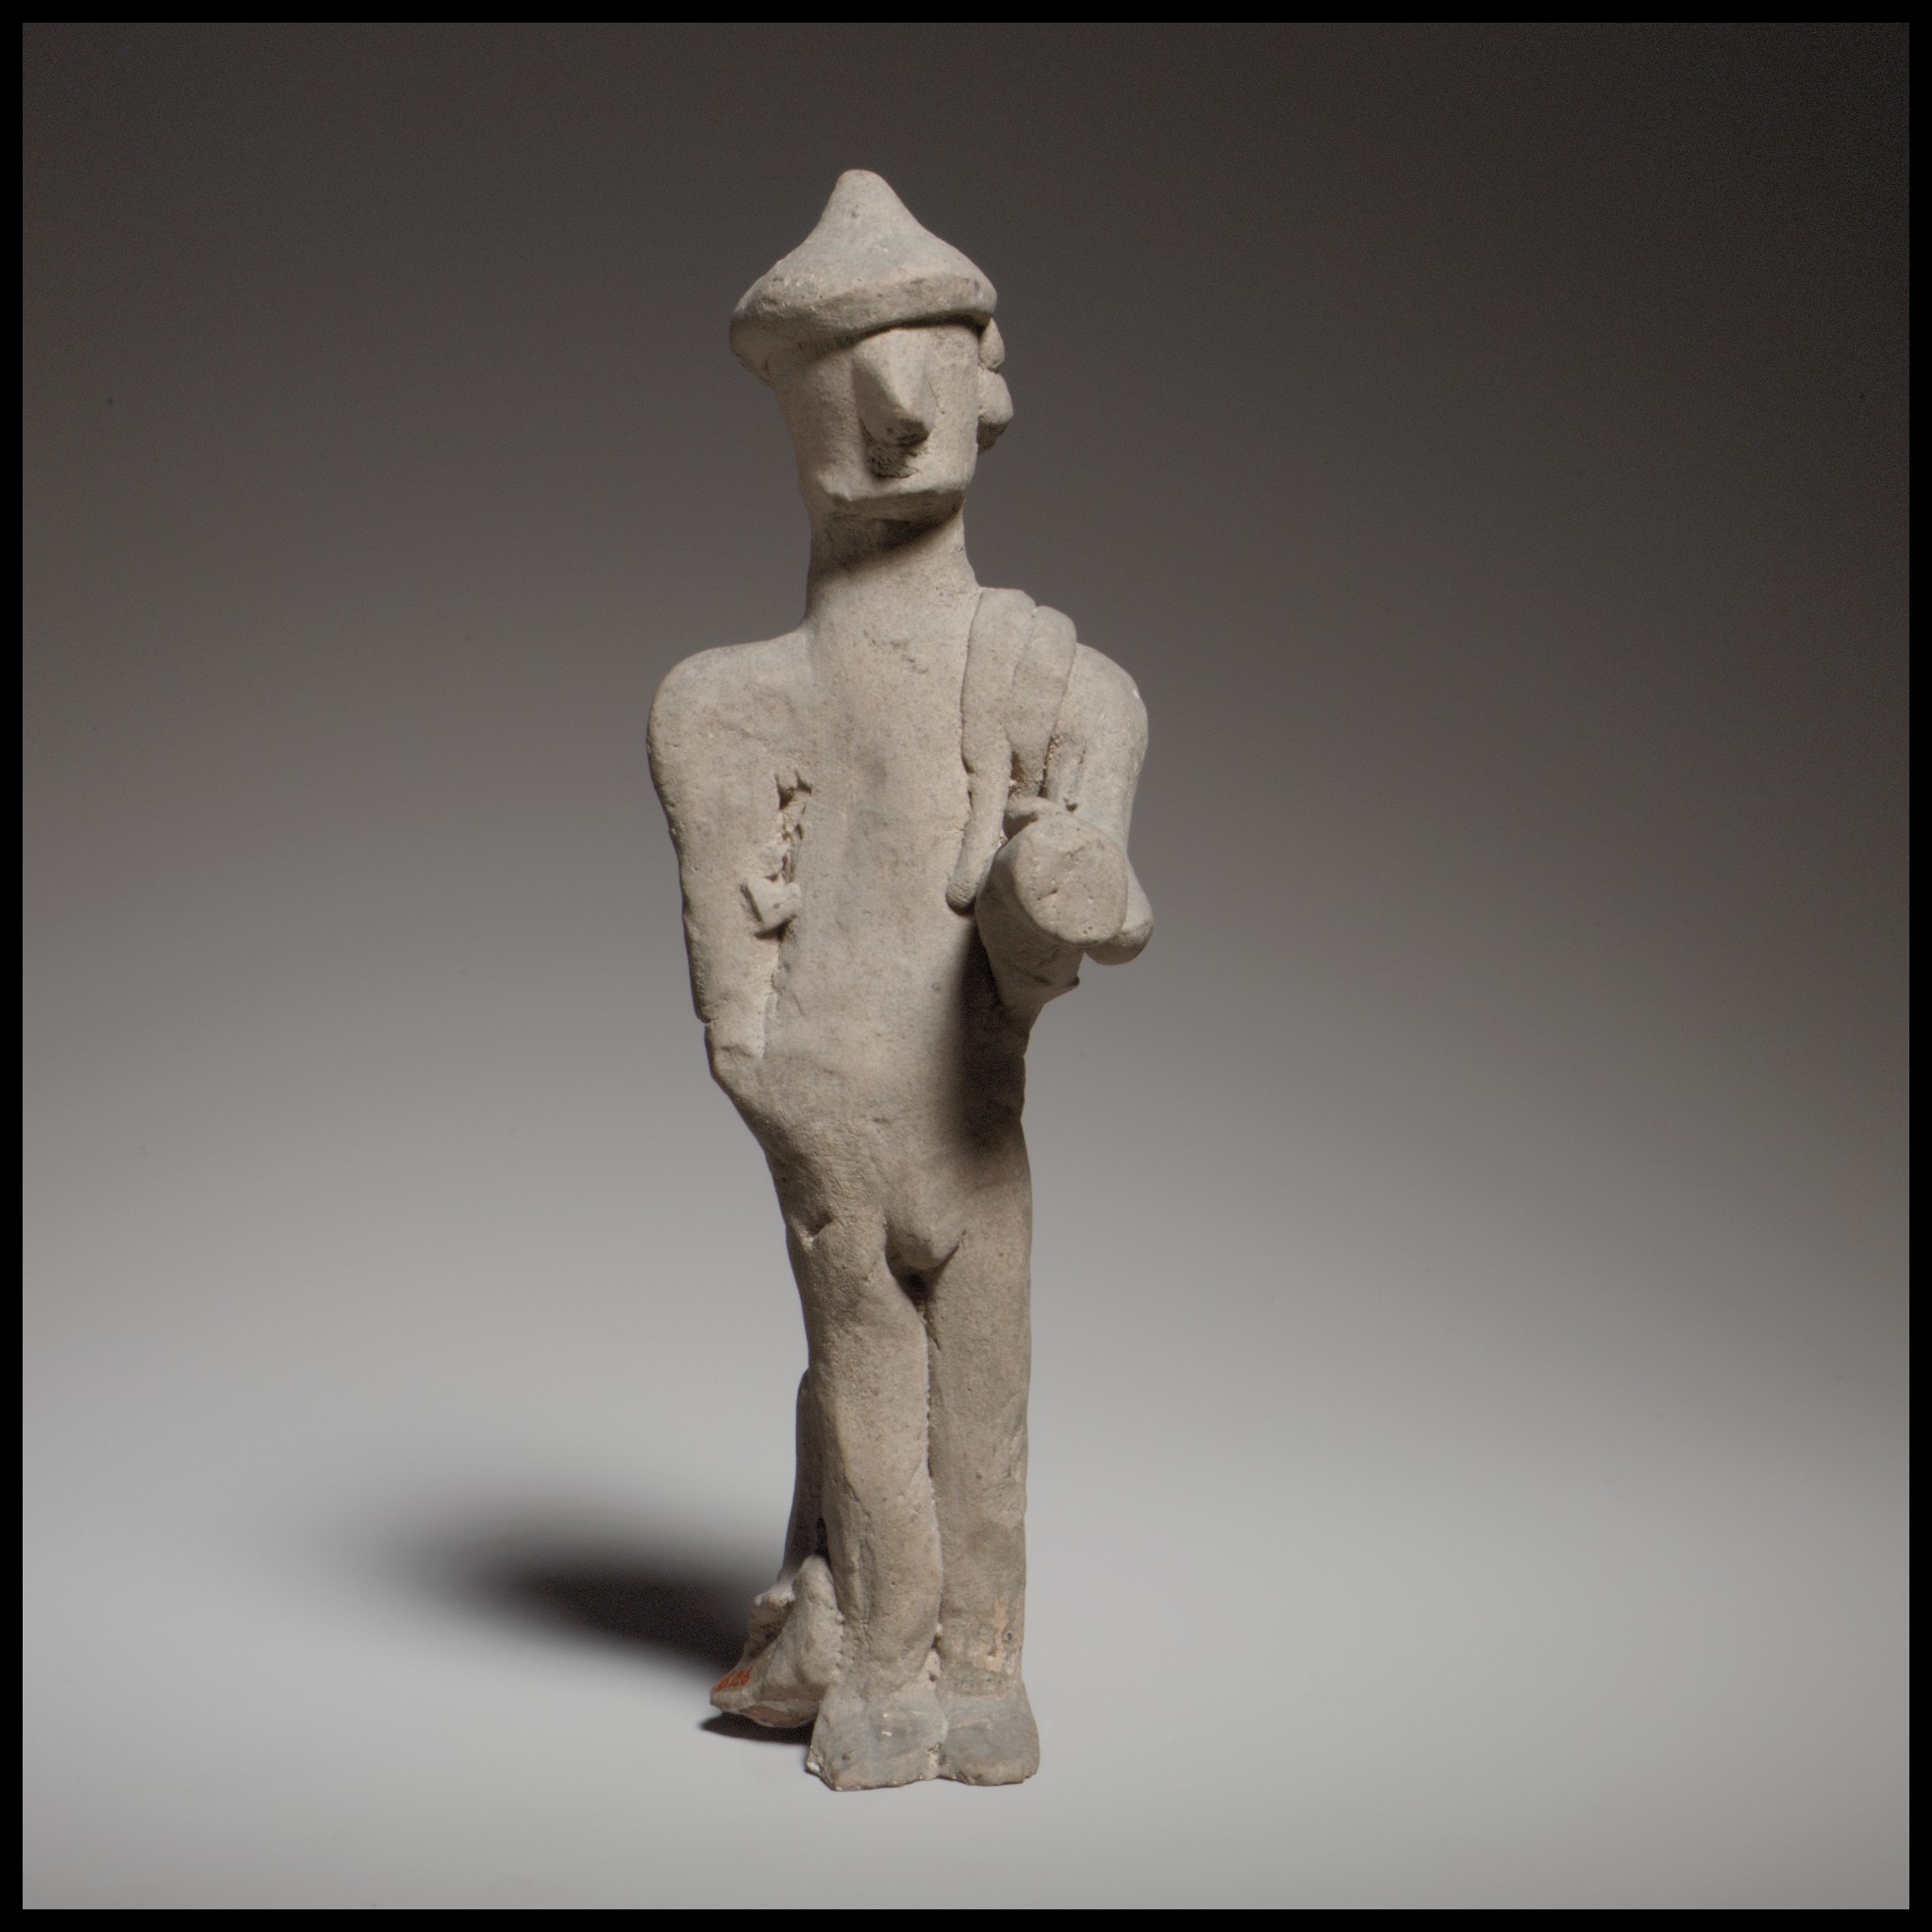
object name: statuette of a votary, male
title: Standing male figurine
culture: cypriot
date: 600-480 BCE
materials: terracotta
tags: men